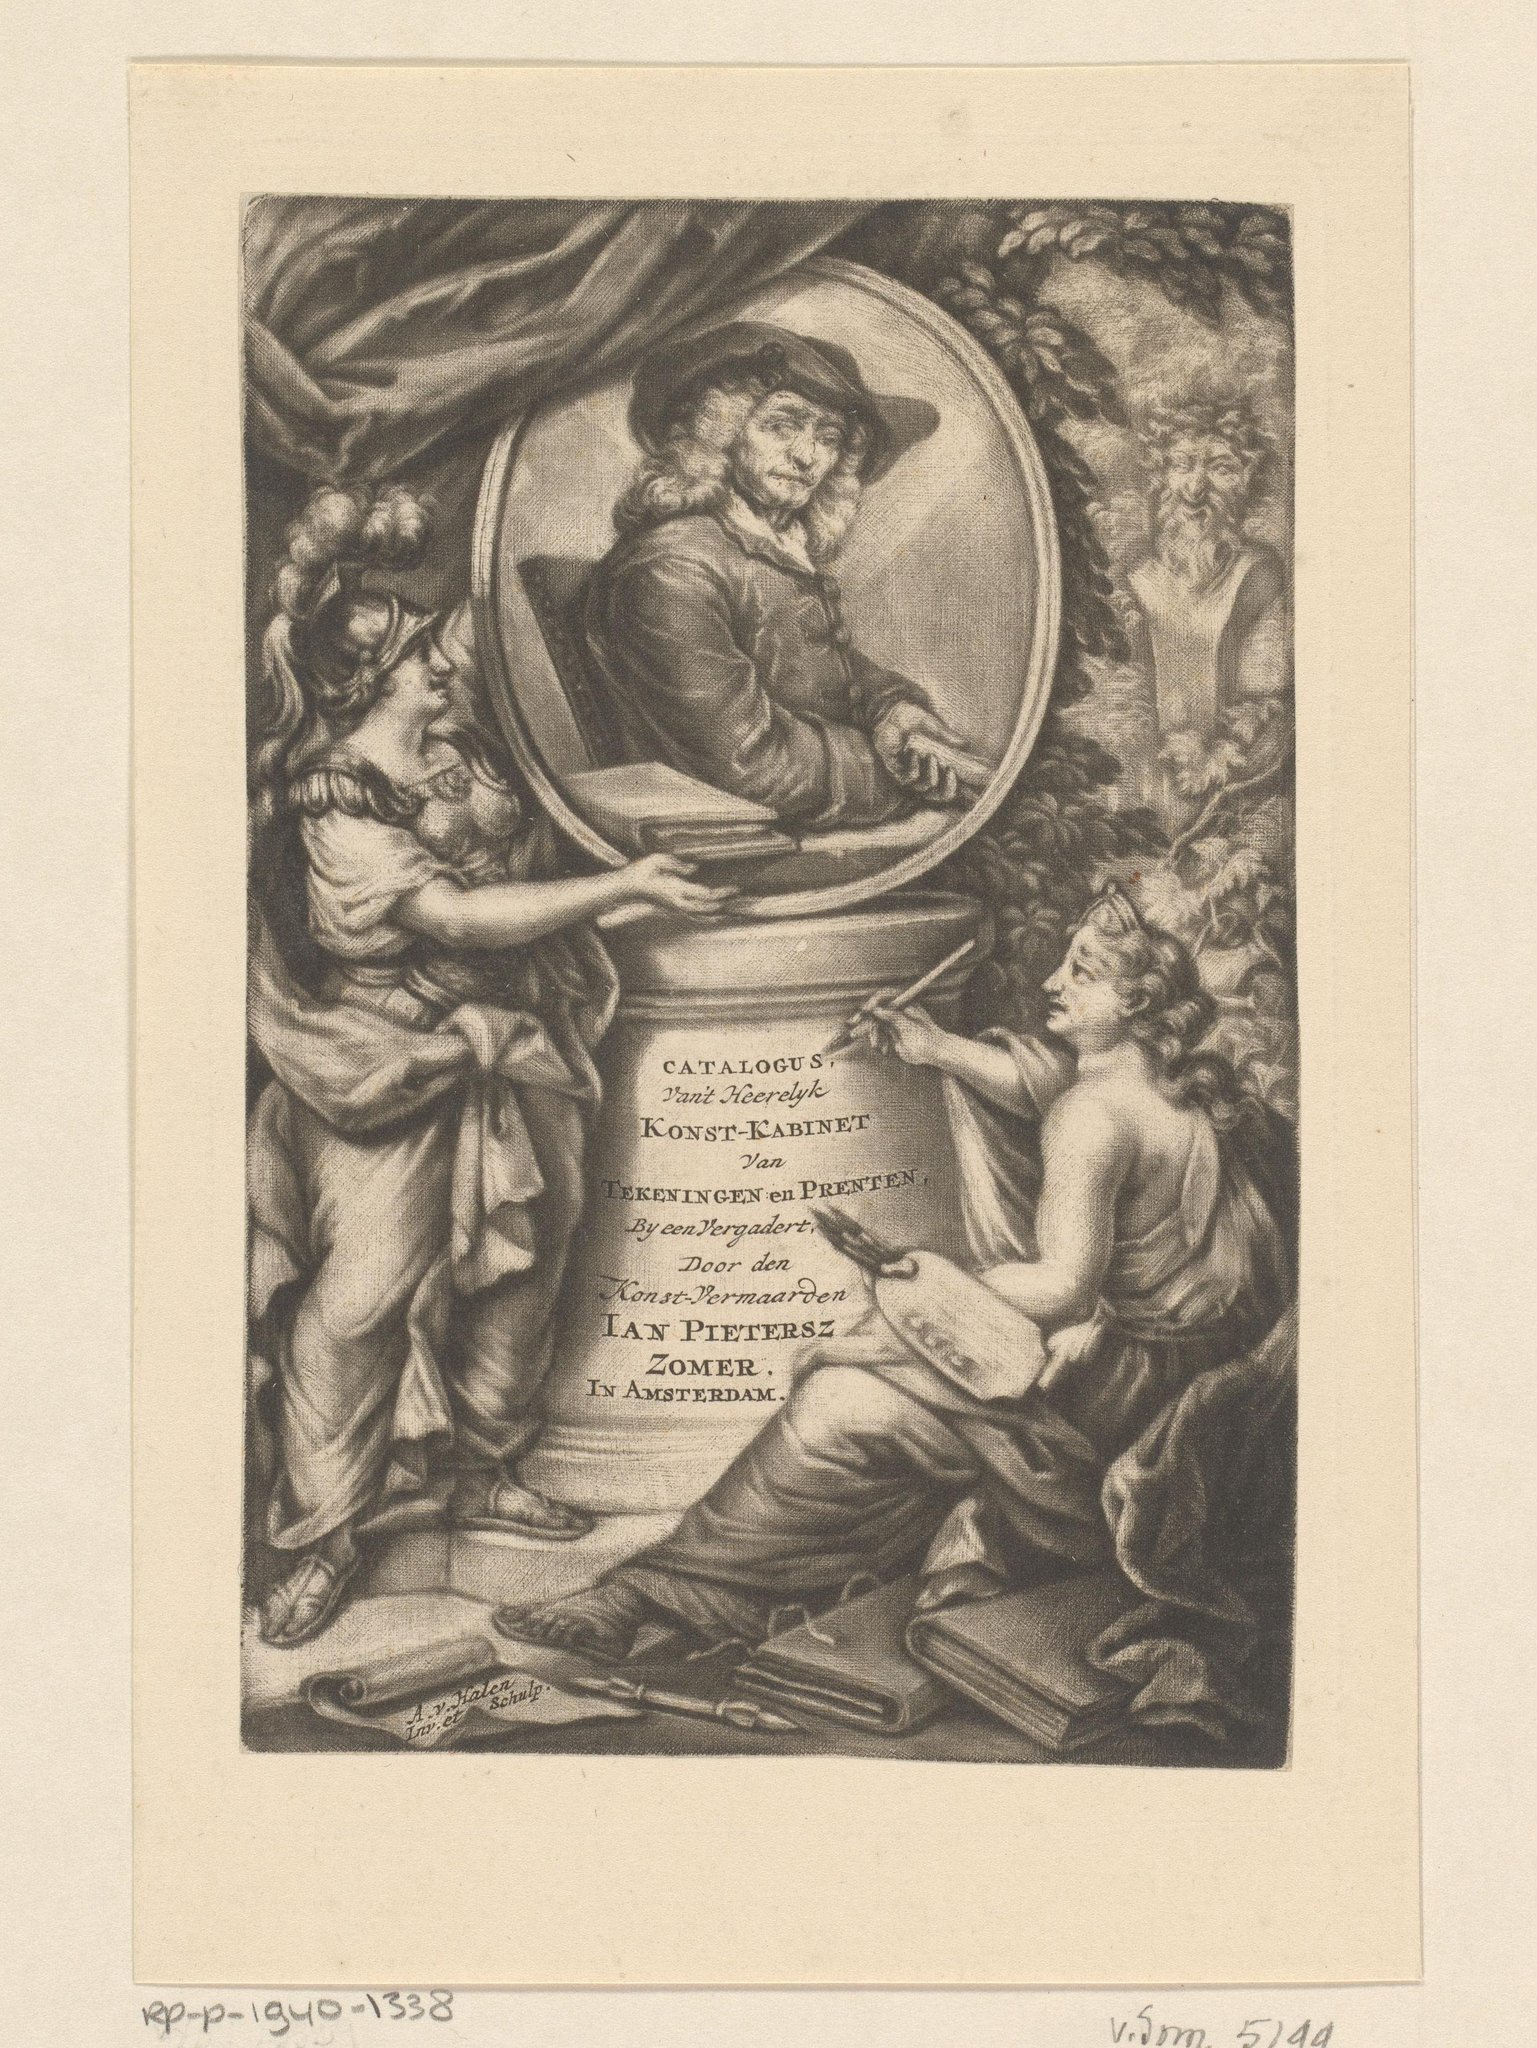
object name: print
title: Portret van Jan Pietersz. Zomer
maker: arnoud van halen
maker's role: draughtsman, painter, print maker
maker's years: 1673-1732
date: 1720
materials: paper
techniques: blind stamped, engraving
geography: amsterdam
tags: amsterdam, draughtsman, jan pietersz. zomer, print, e.g.: engraving, etching, lithograph, historical persons, art dealer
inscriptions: collector's mark: Lugt 2228, collector's mark: Lugt 2760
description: Prent waarschijnlijk uit: Zomer, Jan Pietersz. Catalogus van een uytstekend heerlyk cabinet van teekeningen, (...). S.l.s.n., 1720.